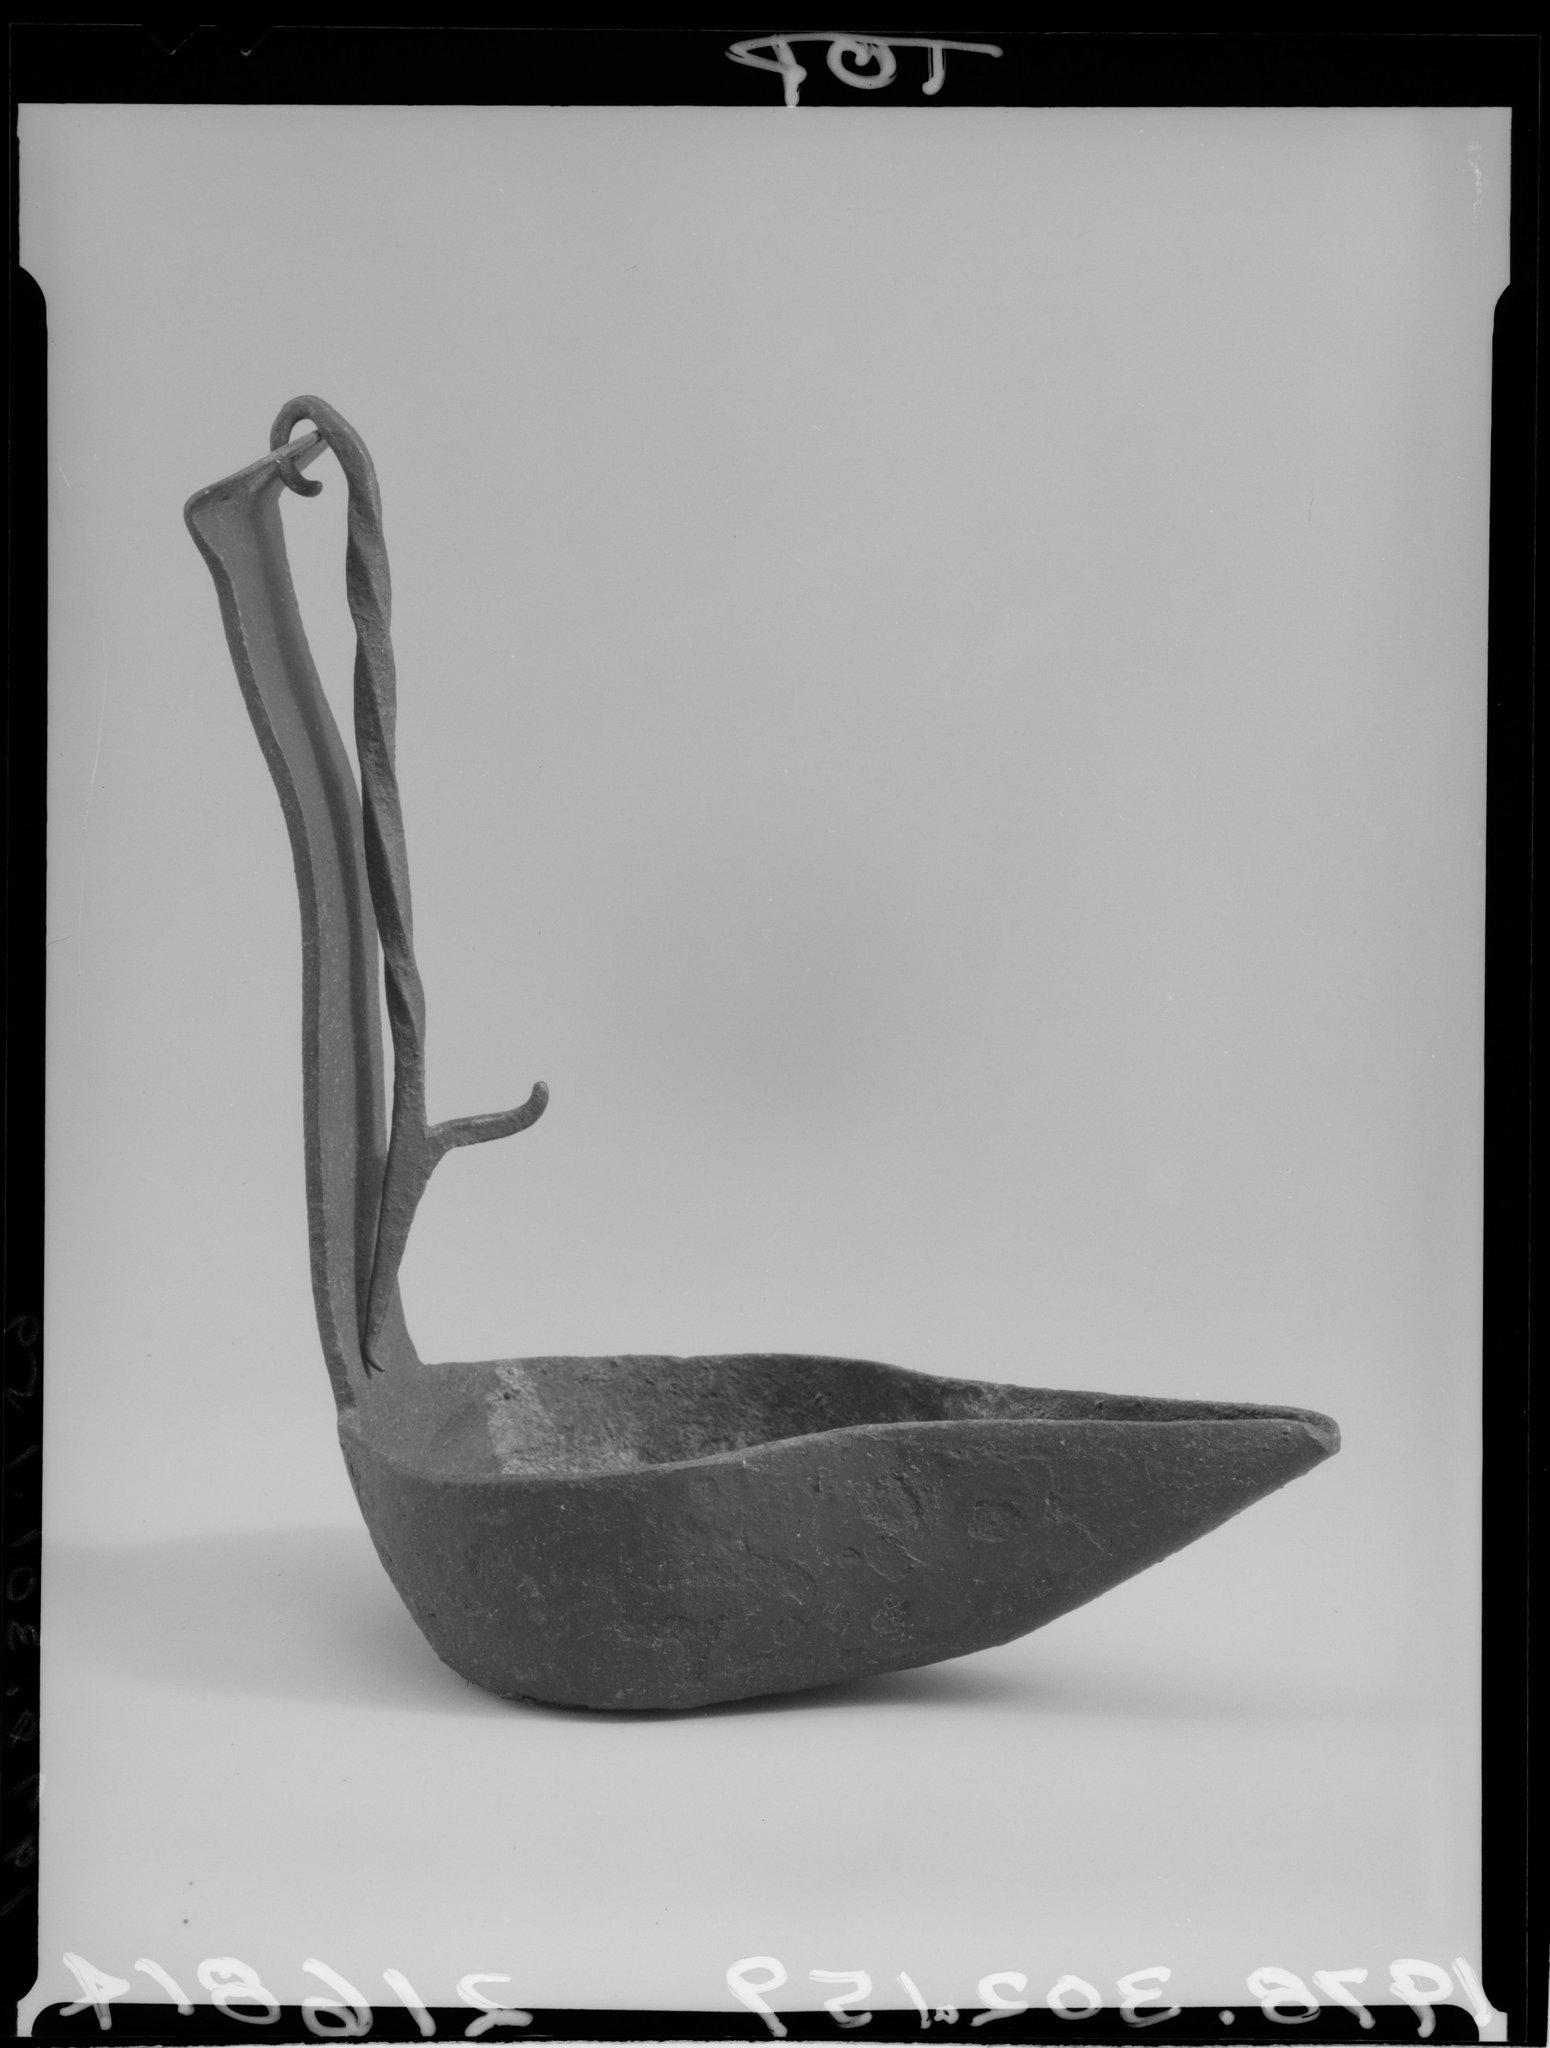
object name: betty lamp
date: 1700-1800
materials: iron